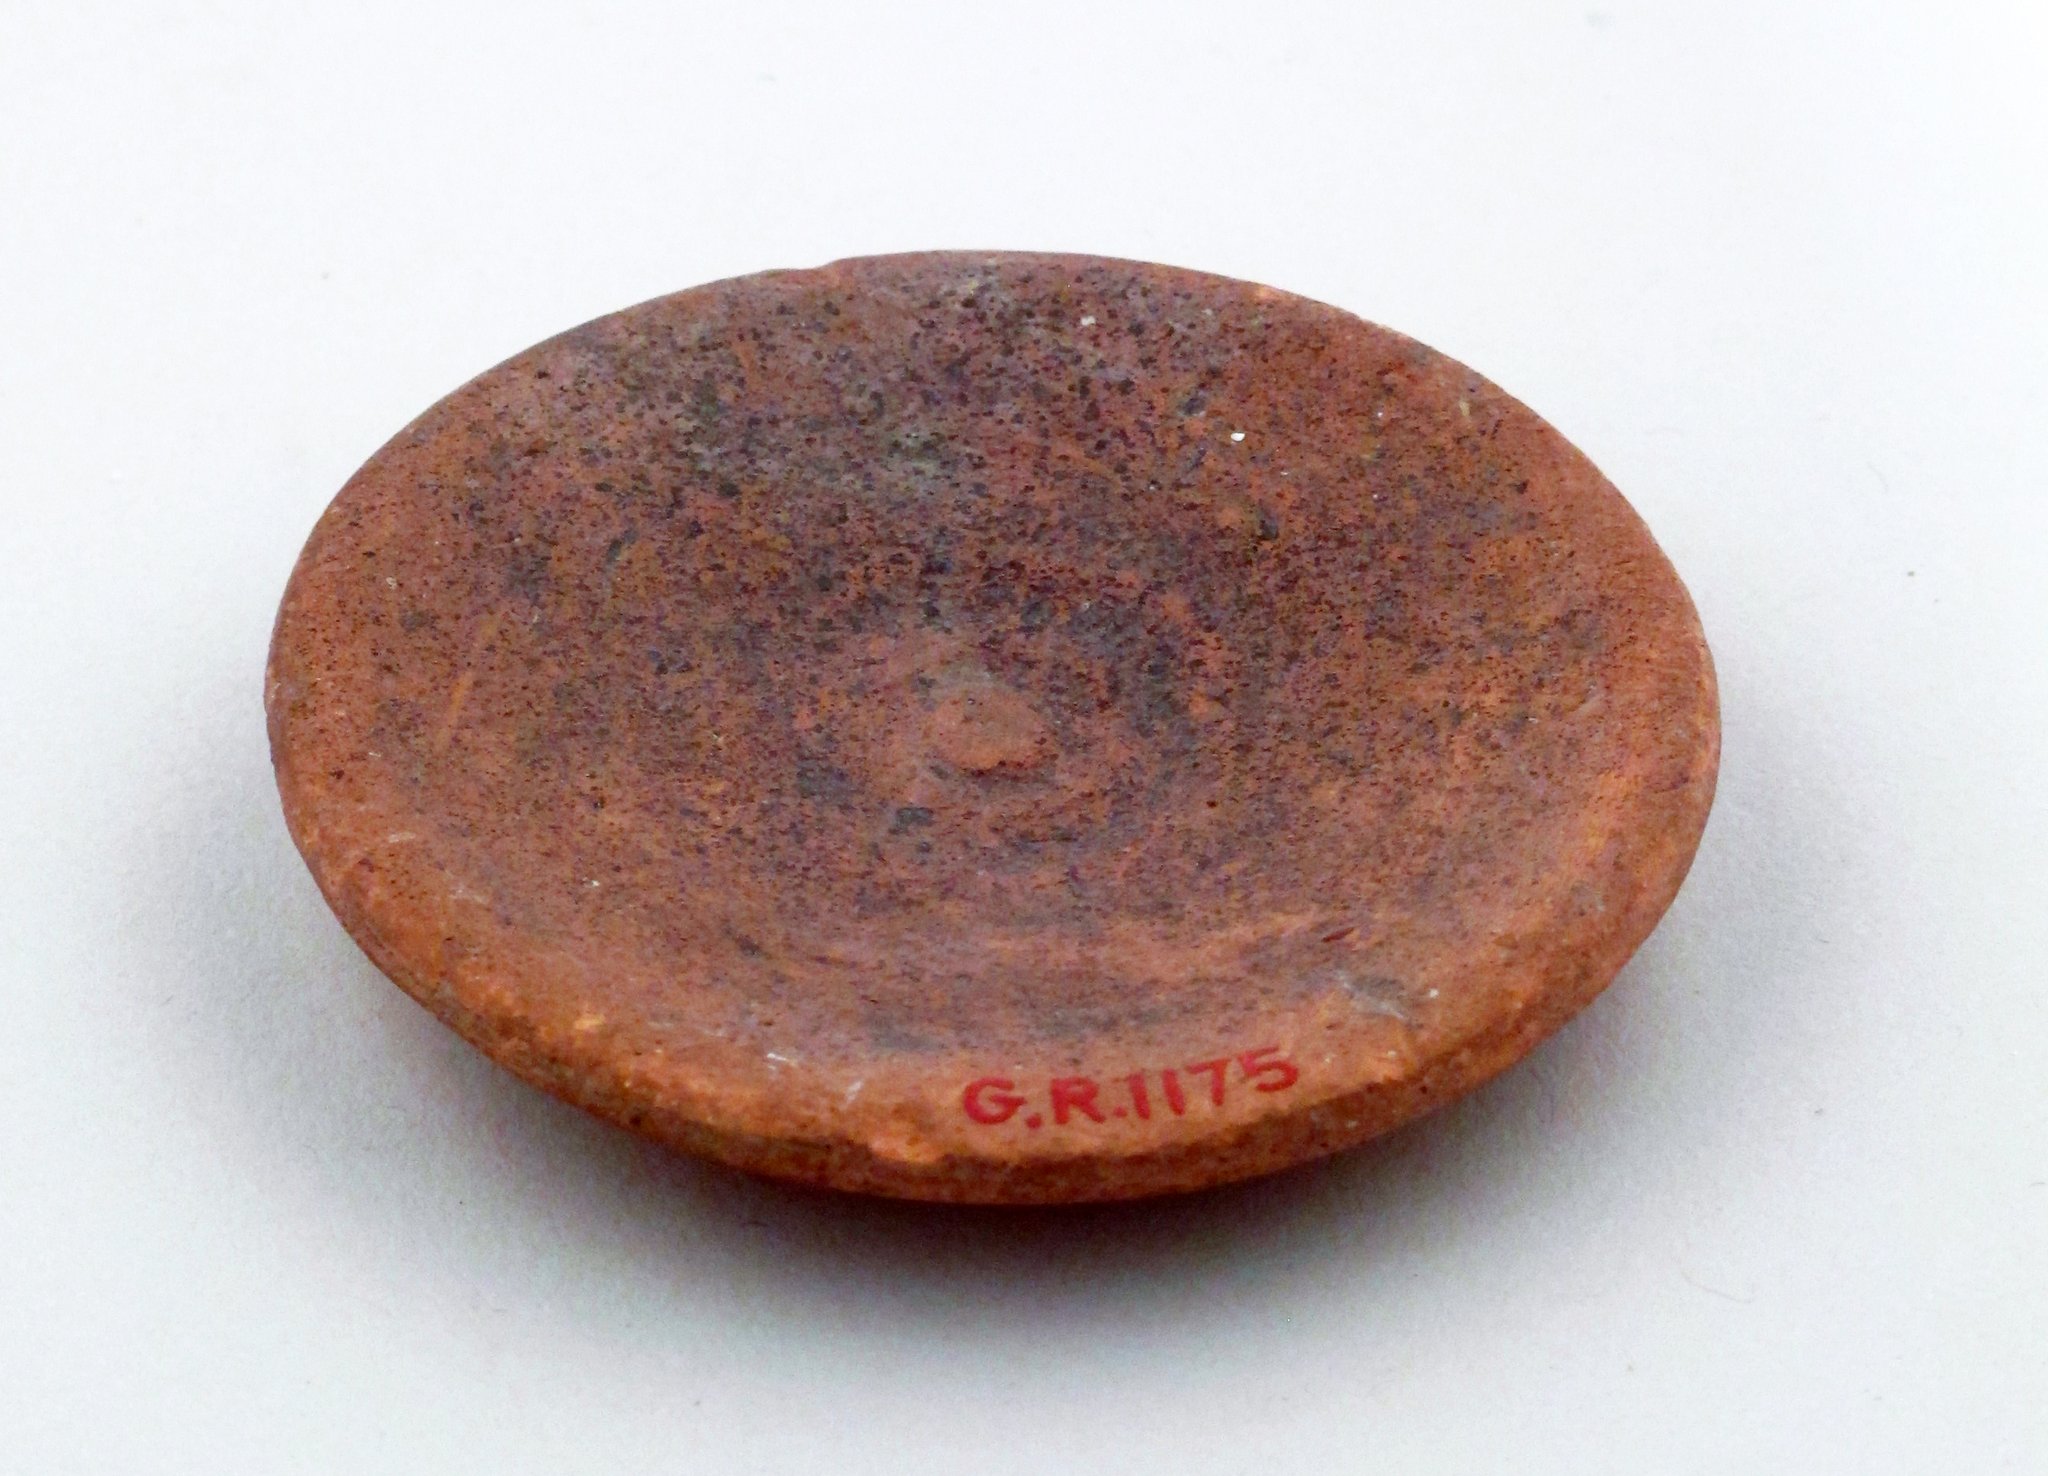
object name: phiale, miniature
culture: etruscan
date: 900-100 BCE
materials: terracotta